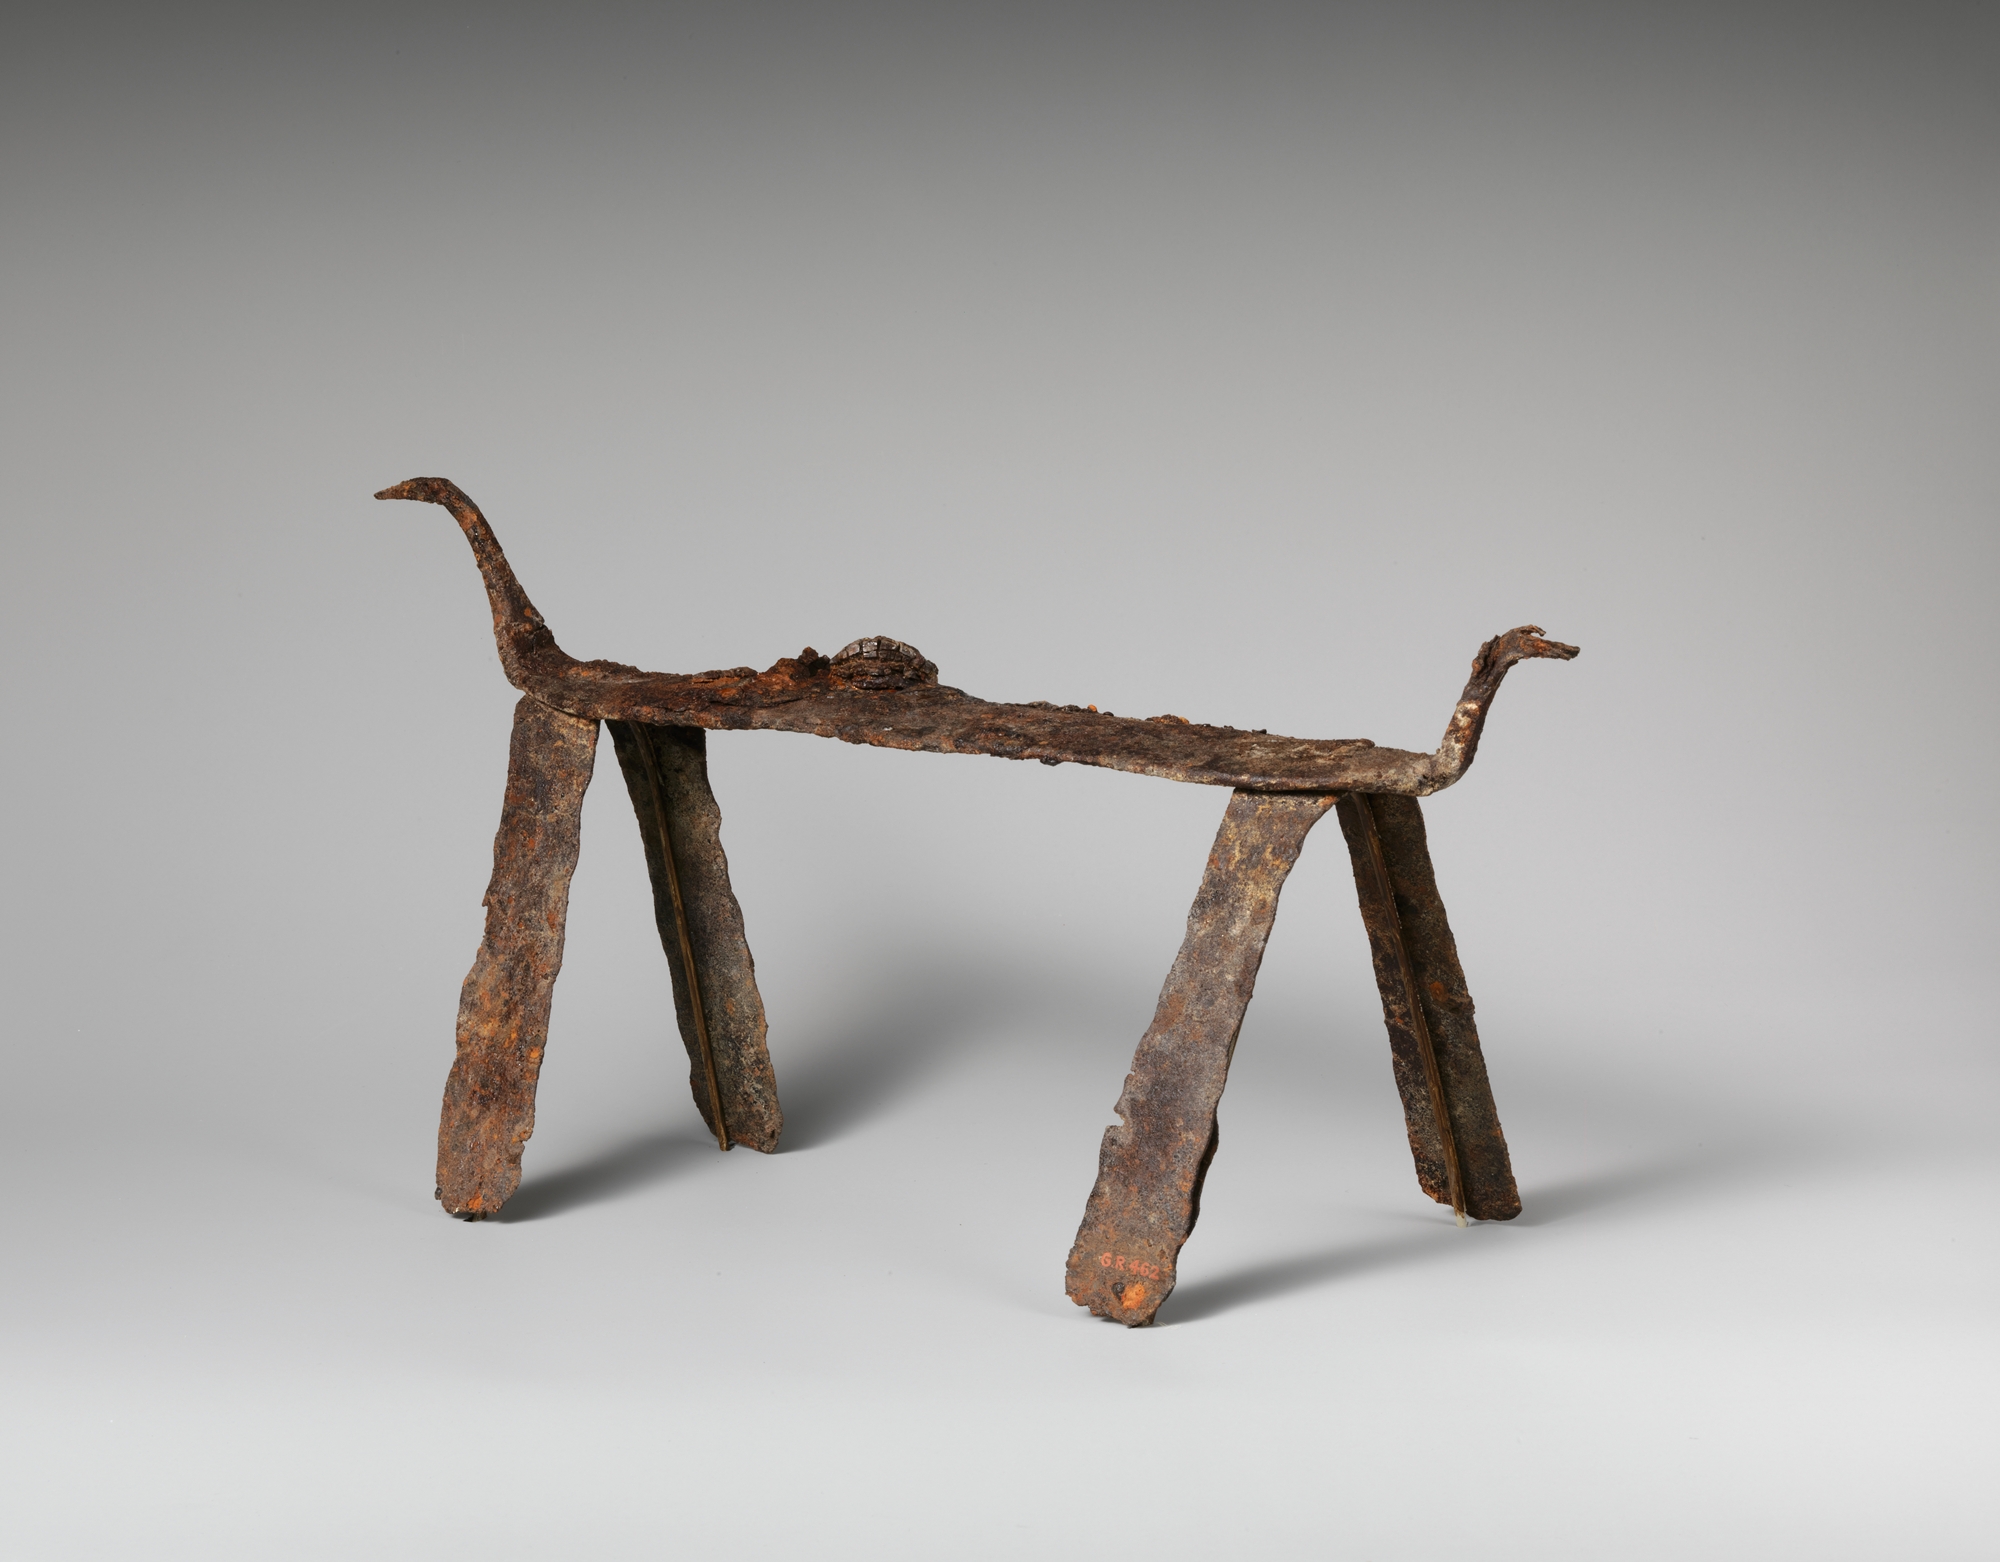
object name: fire, andiron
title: Iron andiron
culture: etruscan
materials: iron